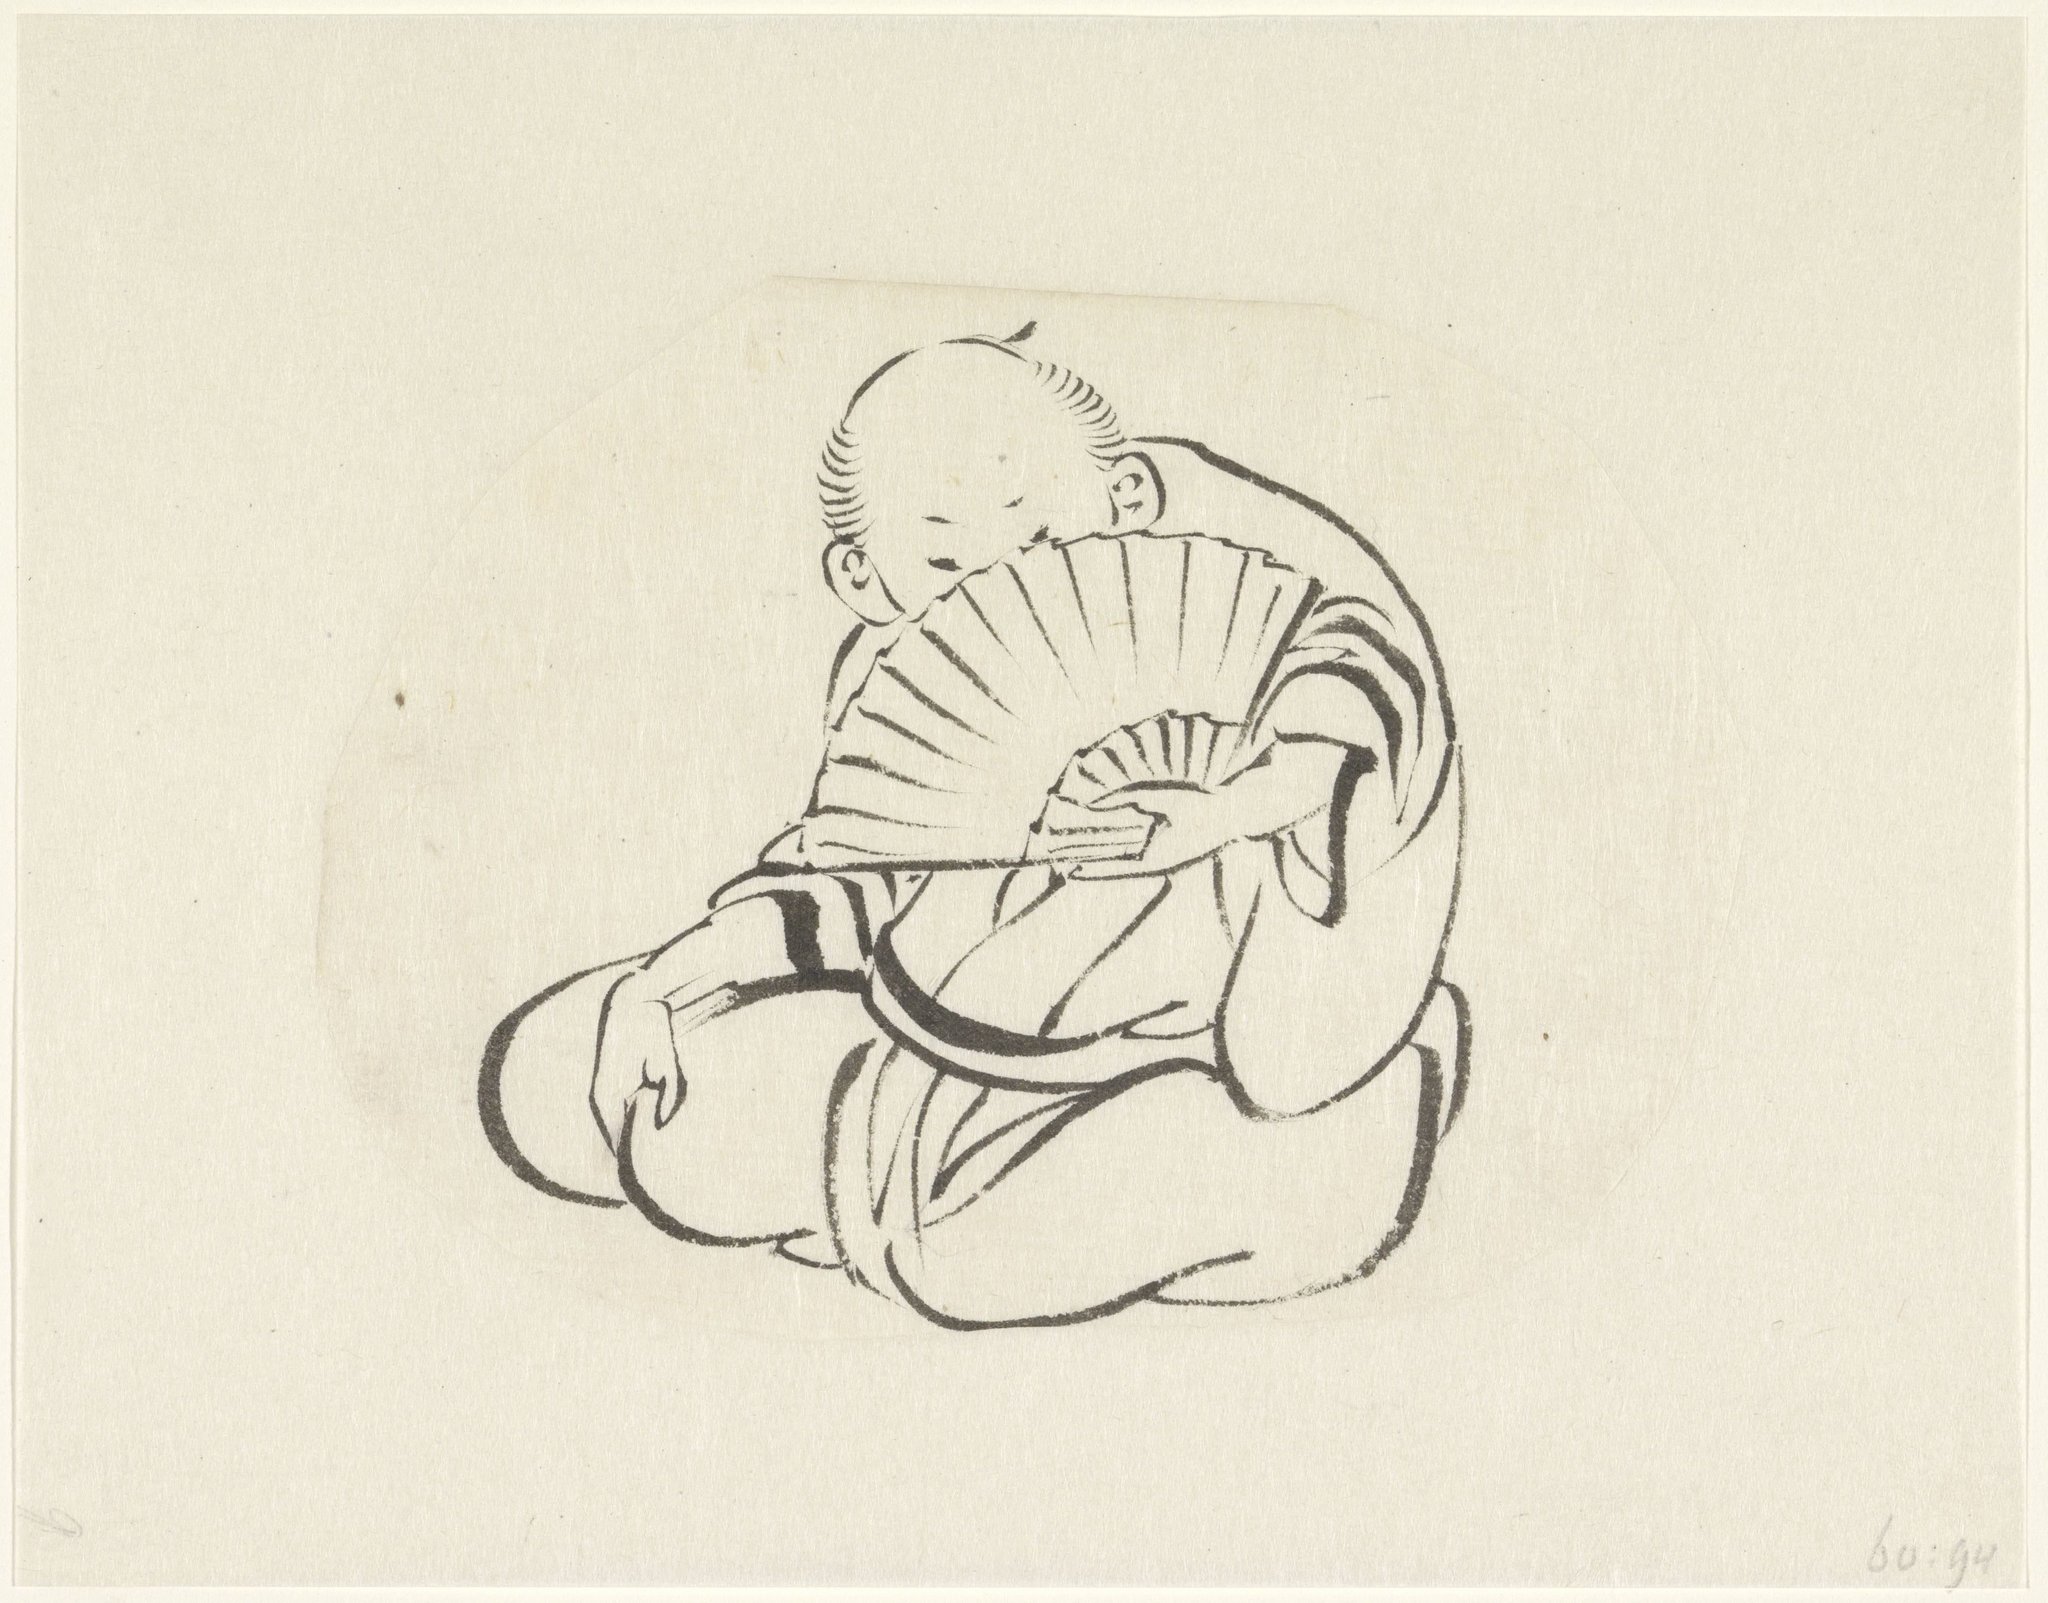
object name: drawing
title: Zittende man, met een waaier voor het gezicht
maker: totoya hokkei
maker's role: print maker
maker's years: 1790-1850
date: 1791-1850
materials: paper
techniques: brush